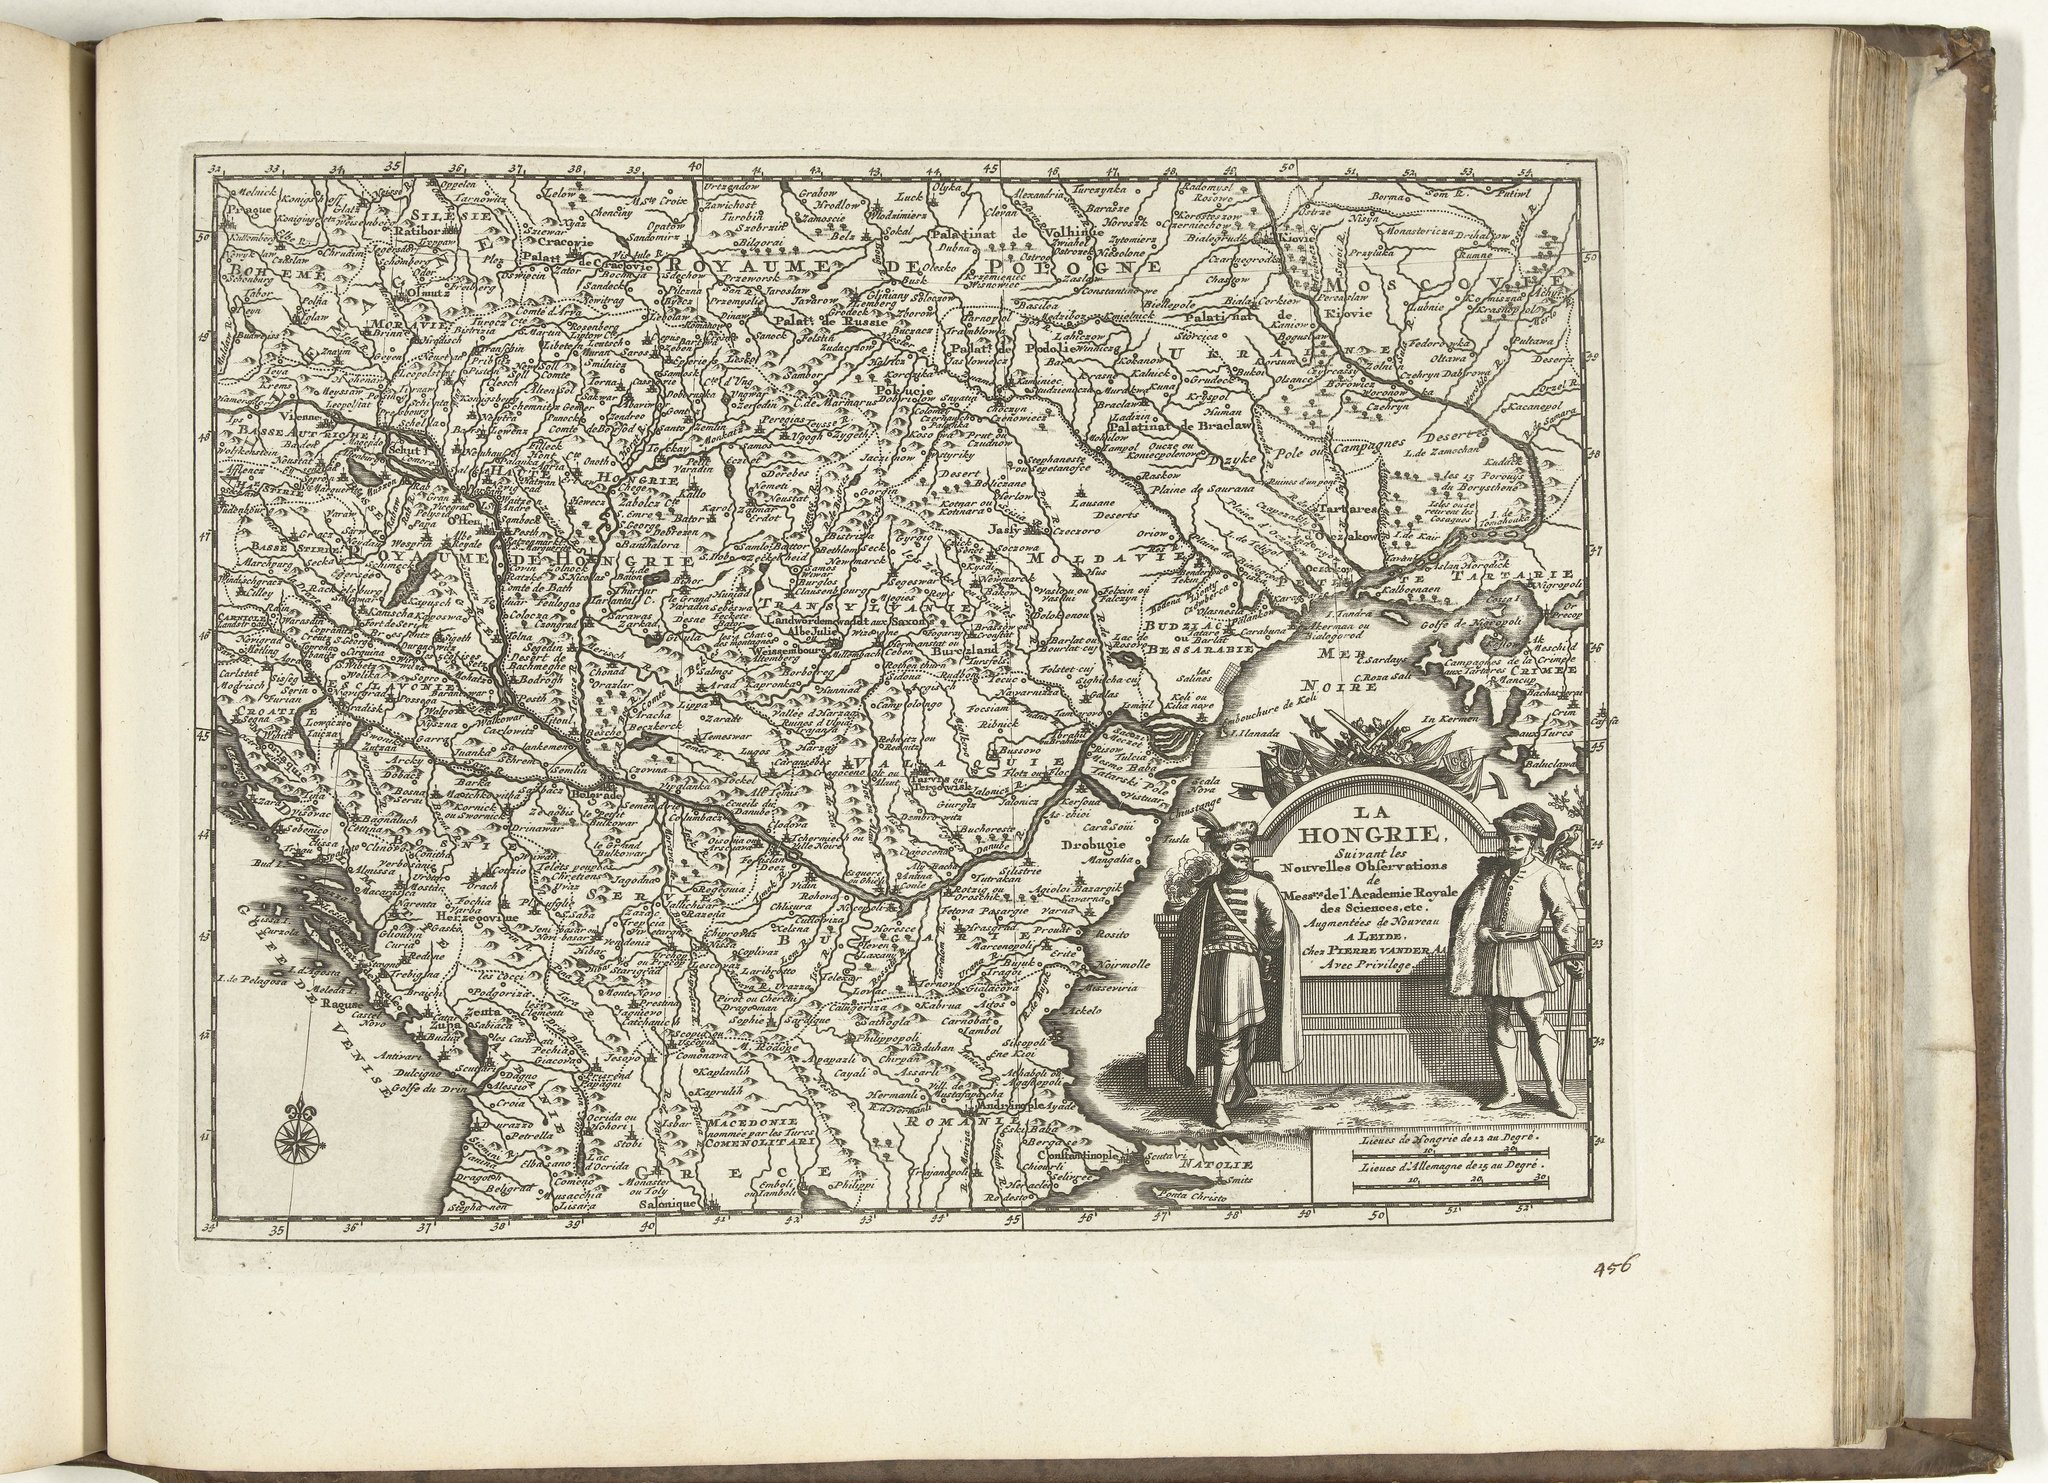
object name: print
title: La Hongrie, Suivant les Nouvelles Observations (...)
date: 1726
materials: paper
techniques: engraving, etching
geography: leiden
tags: maps of separate countries or regions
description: Kaart van Hongarije. Plaat nr. 456 in deel XVIII van het prentwerk: Les Forces de l'Europe, Asie, Afrique et Amerique ... Comme aussi les Cartes des Côtes de France et d'Espagne uit 1726, dit tweede deel met 271 met de hand genummerde platen van vermaarde sterke steden en vestingen in het kader van de Spaanse Successieoorlog 1701-1713. Voor het merendeel zijn deze platen gekopieerd naar de anonieme Franse platen van vermaarde sterke steden en vestingen: in Les forces de l'Europe en in: Le theatre de la guerre, dans les Pays-Bas, beide oorspronkelijk uitgegeven door Nicolas de Fer te Parijs (1693-1697) in het kader van de Negenjarige Oorlog. Titel en opschriften in het Frans.